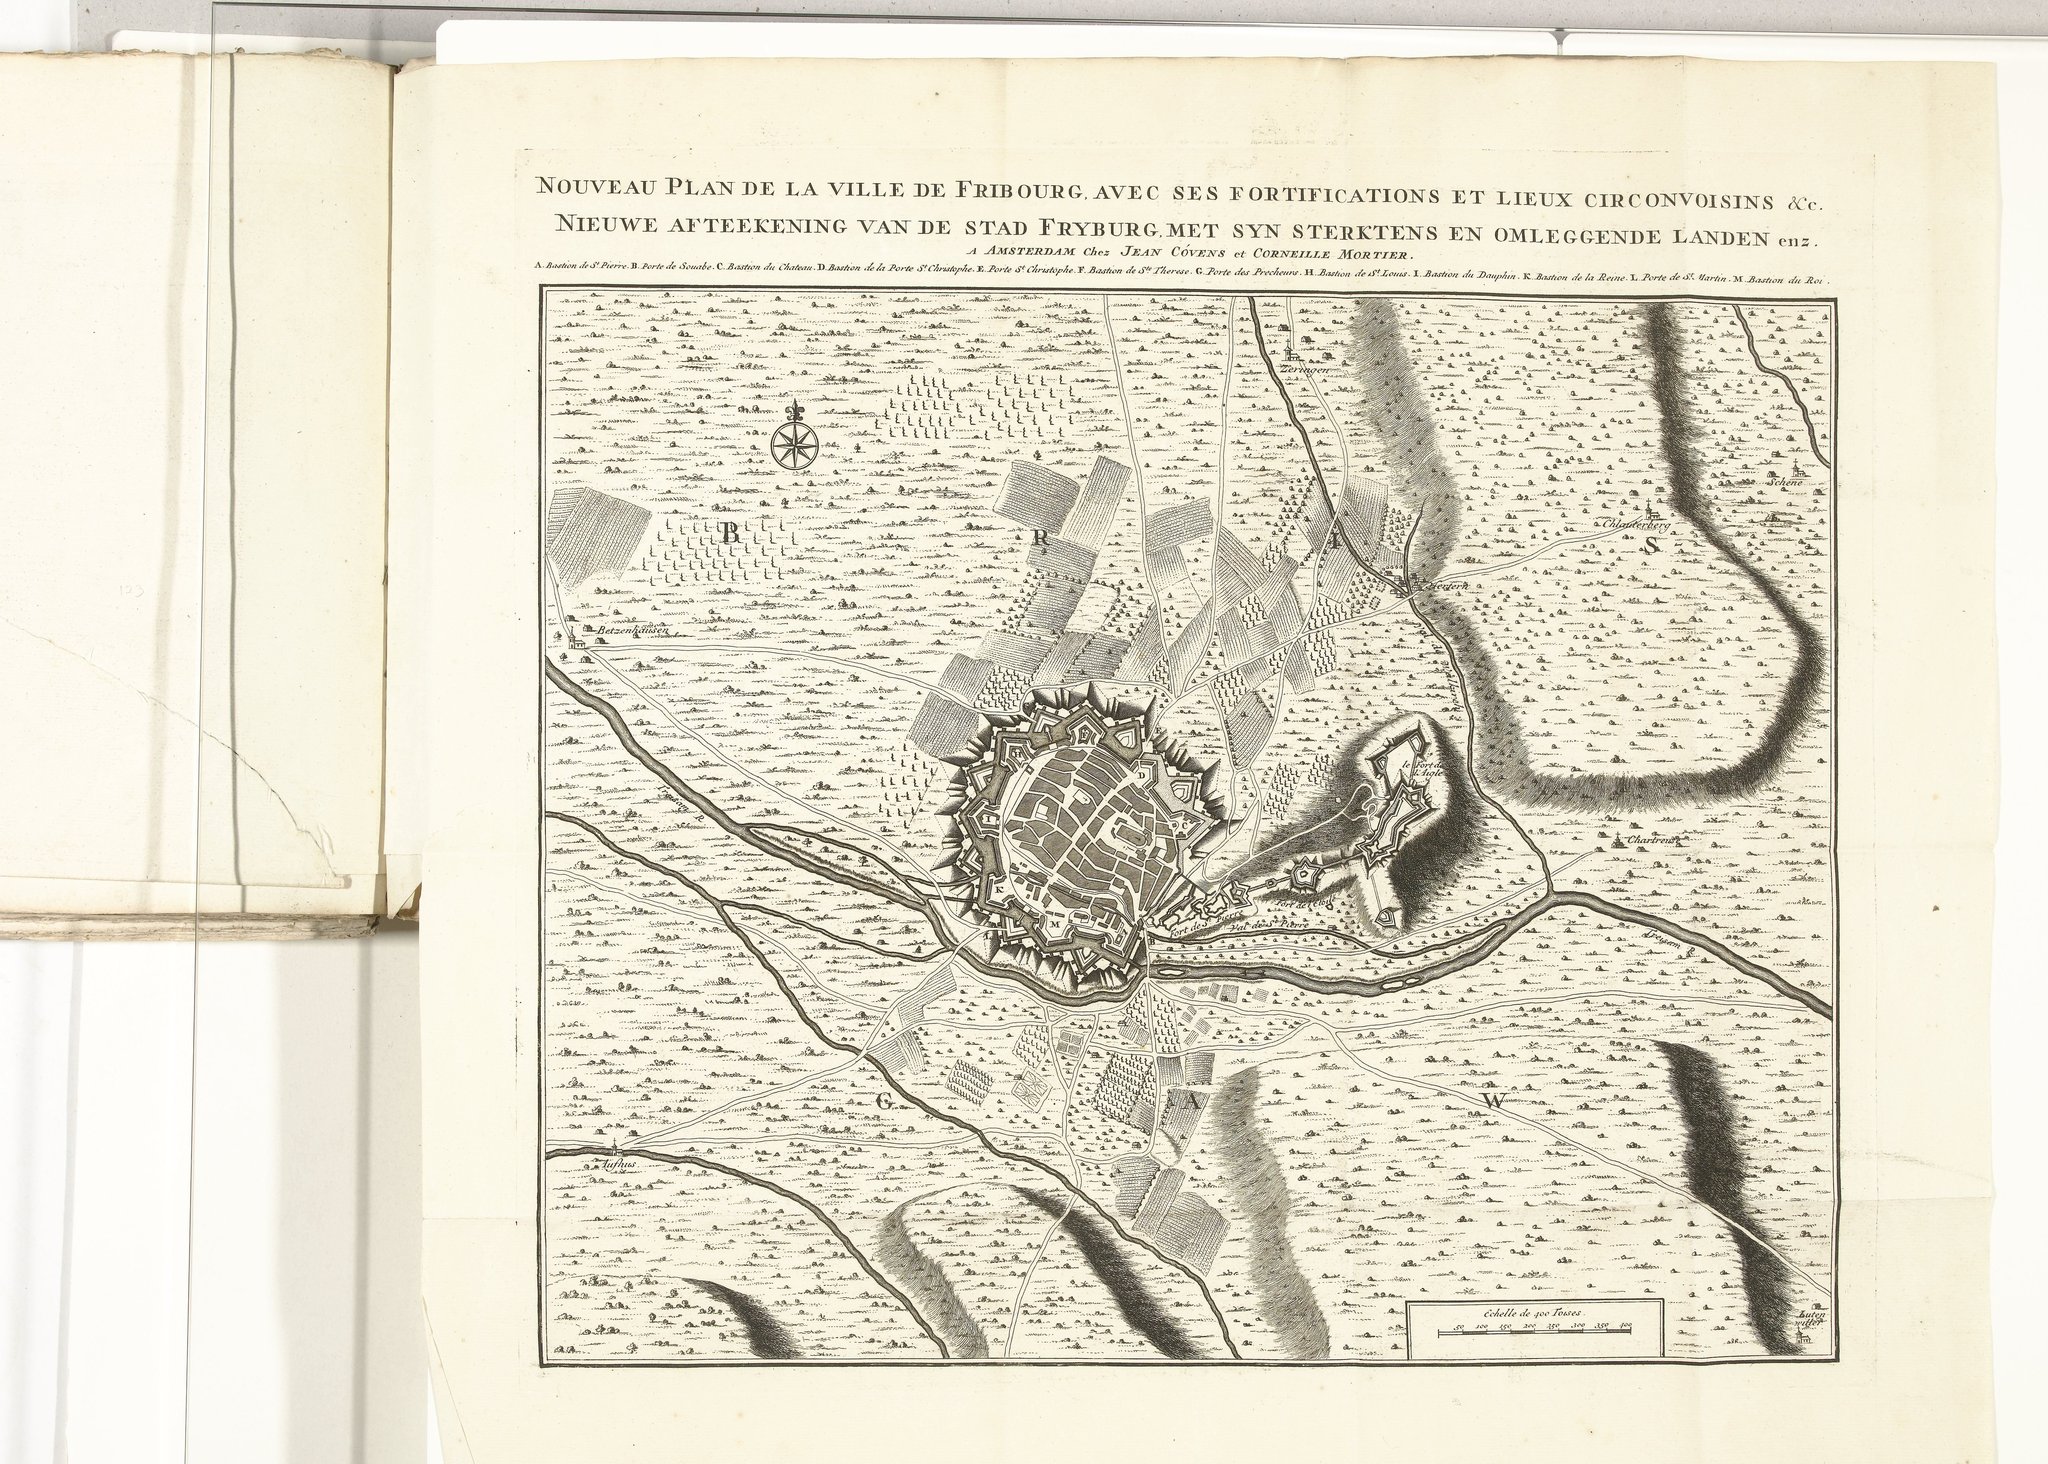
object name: print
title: Nouveau plan de la ville de Fribourg, avec ses fortifications et lieux circonvoisins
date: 1702-1703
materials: paper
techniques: etching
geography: amsterdam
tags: fortress, maps of cities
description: Grote kaart met plattegrond van de versterkingen om de stad Fribourg. Ongenummerde plaat [nr. 120B] in het prentwerk bestaande in totaal uit 276 genummerde platen van vermaarde sterke steden en vestingen in het kader van de Spaanse Successieoorlog. Voor het merendeel zijn deze platen gekopieerd naar de anonieme Franse platen: in Les forces de l'Europe en in: Le theatre de la guerre, dans les Pays-Bas, beide oorspronkelijk uitgegeven door Nicolas de Fer te Parijs (1693-1697) in het kader van de Negenjarige Oorlog. Opschriften in de plaat in het Frans. Later toegevoegd aan het album (?).